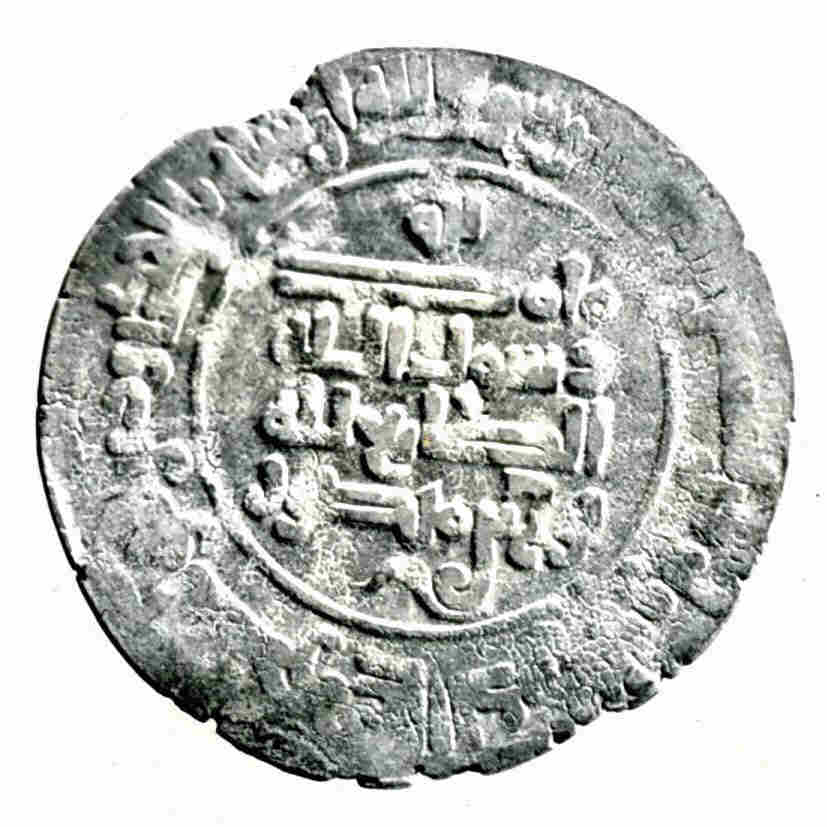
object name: coin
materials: silver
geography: uzbekistan